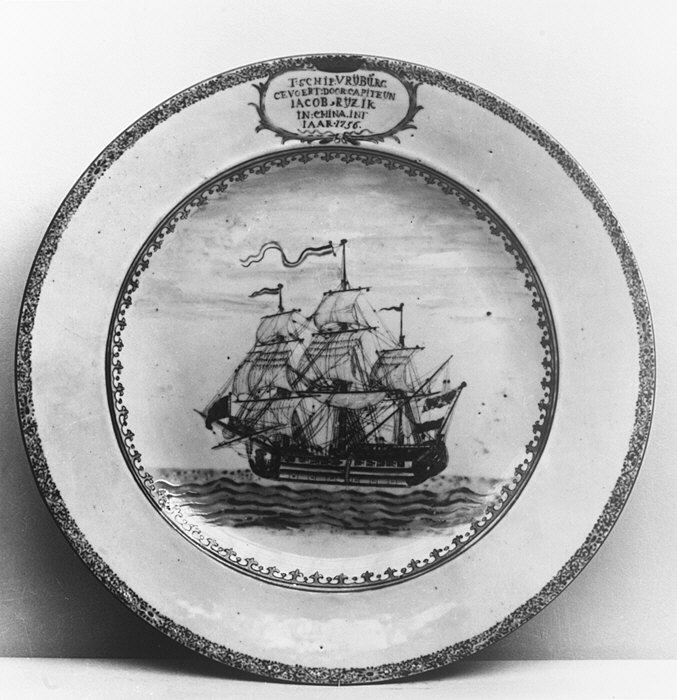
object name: plate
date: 1756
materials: hard paste porcelain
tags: ships